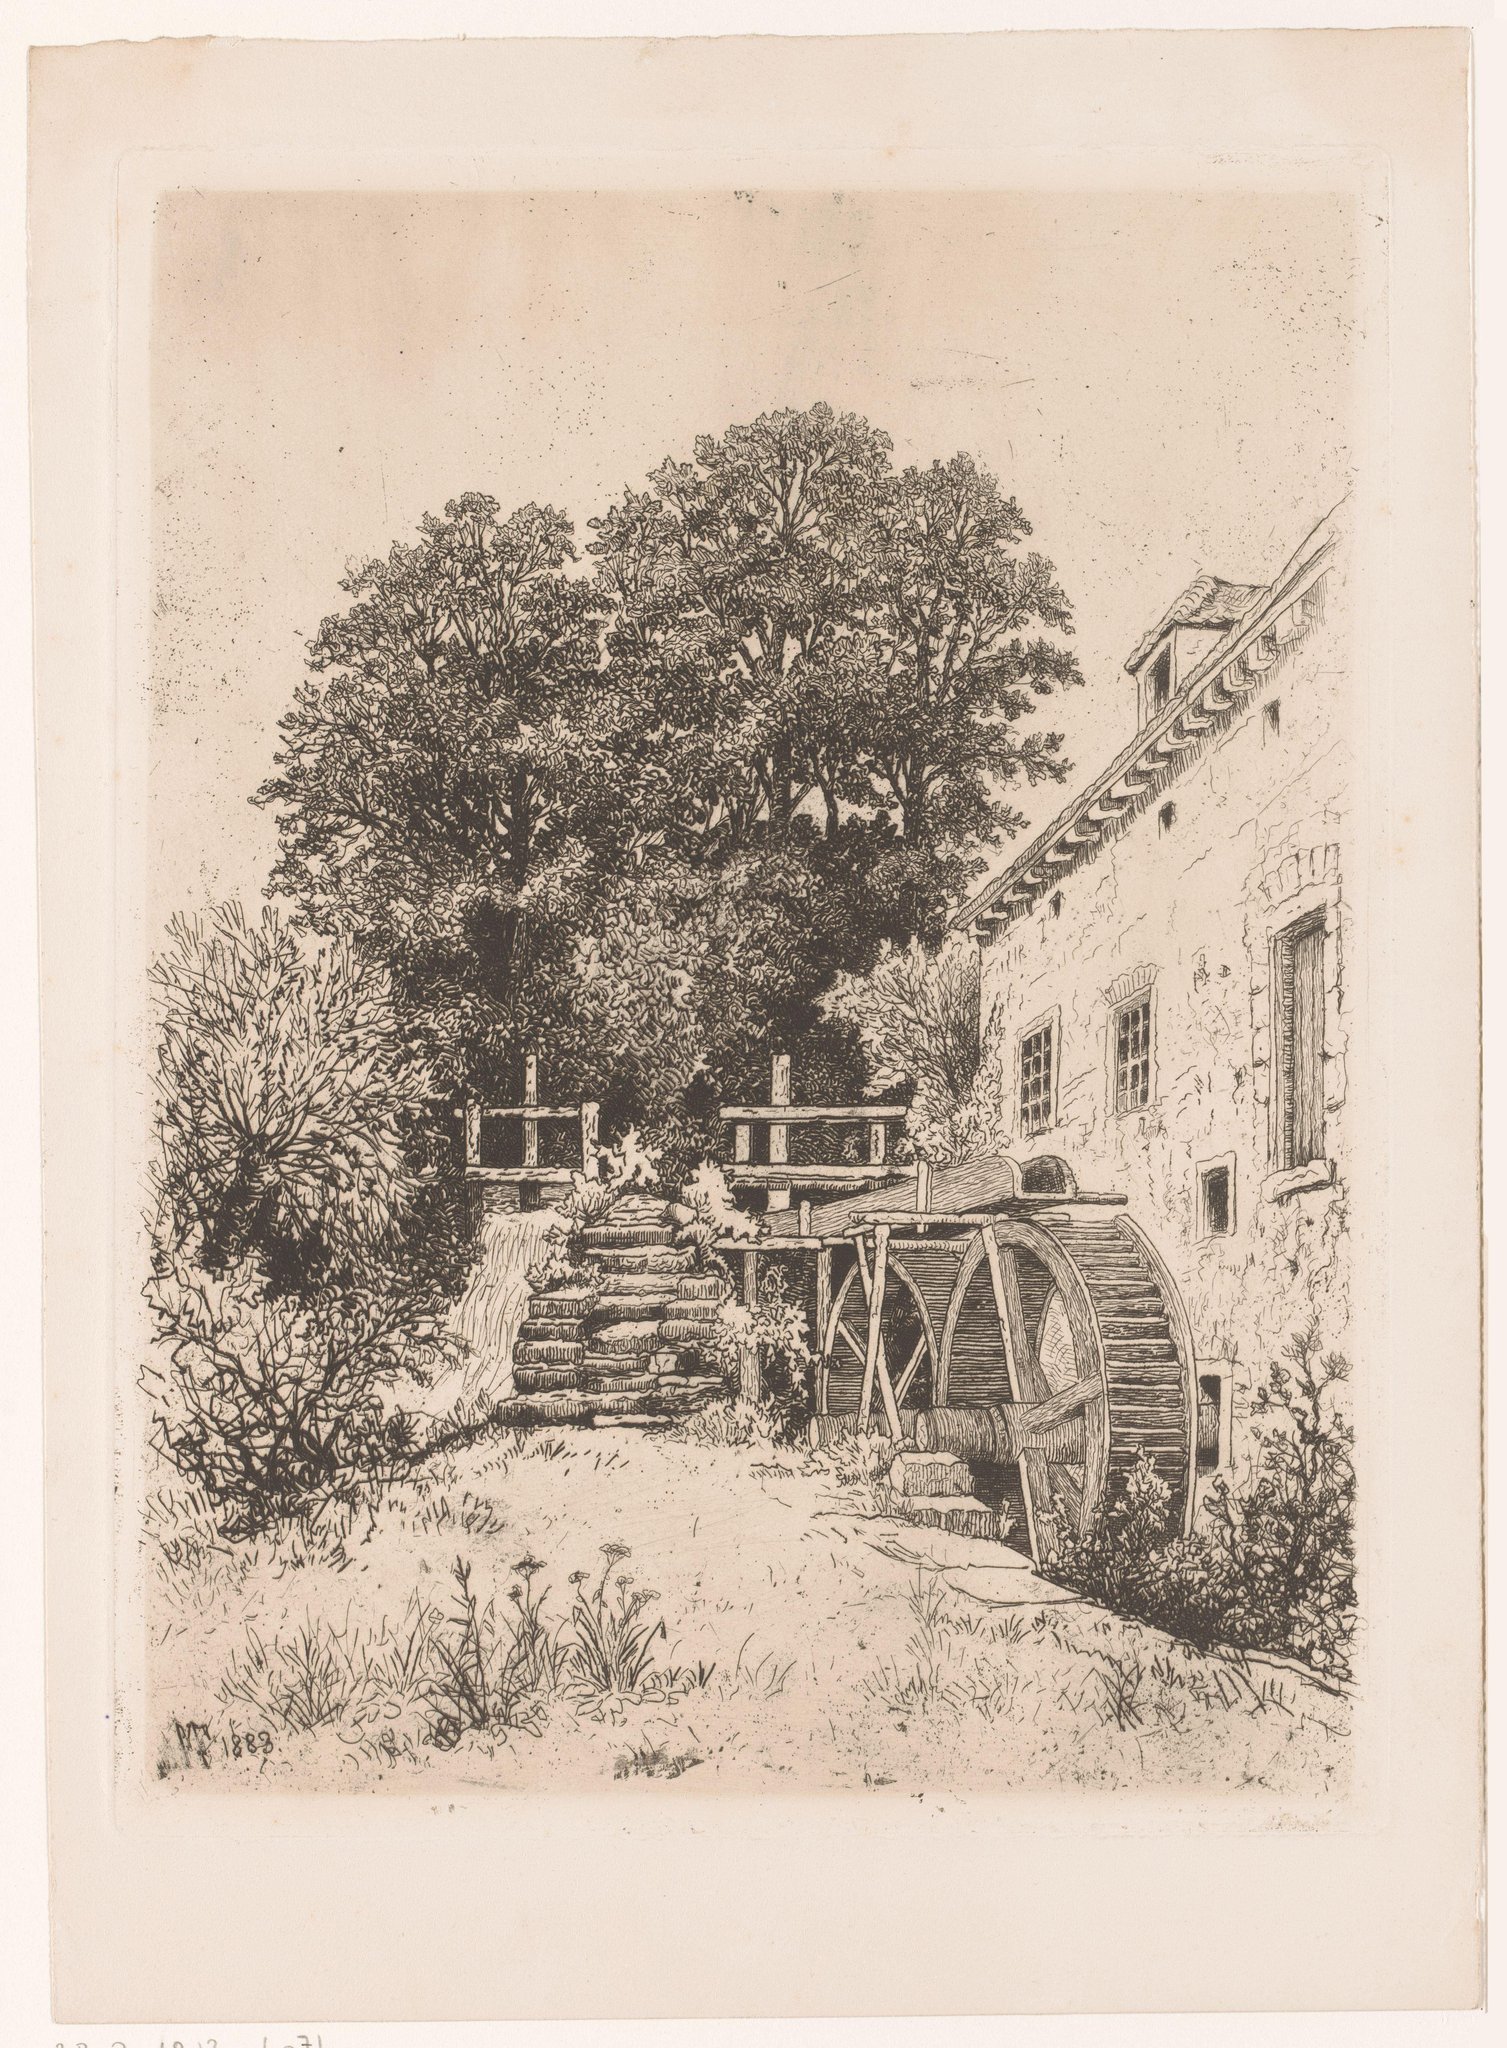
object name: print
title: Watermolen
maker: maria van hohenzollern-sigmaringen (gravin van vlaanderen)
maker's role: print maker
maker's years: 1845-1912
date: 1883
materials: paper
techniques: drypoint, etching, intaglio, retroussage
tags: paddle wheel, watermill in landscape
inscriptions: collector's mark: Lugt 2228